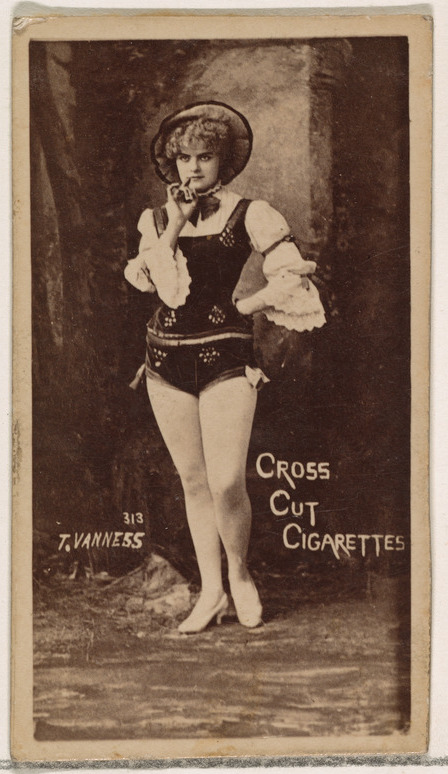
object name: print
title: Card Number 313, T. Vanness, from the Actors and Actresses series (N145-1) issued by Duke Sons & Co. to promote Cross Cut Cigarettes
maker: w. duke, sons & co.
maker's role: publisher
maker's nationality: american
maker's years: 1870-1920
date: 1880-1889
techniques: albumen silver print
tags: portraits,women,actresses